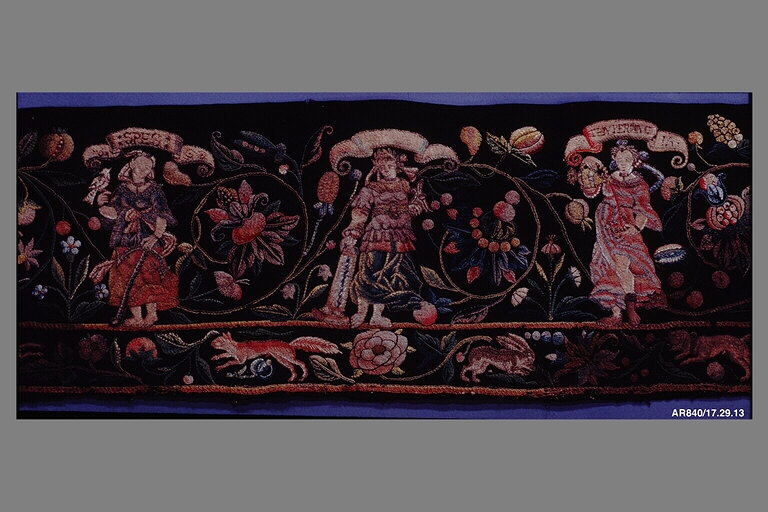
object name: valance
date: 1580-1620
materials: silk, wool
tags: animals,birds,women,flowers